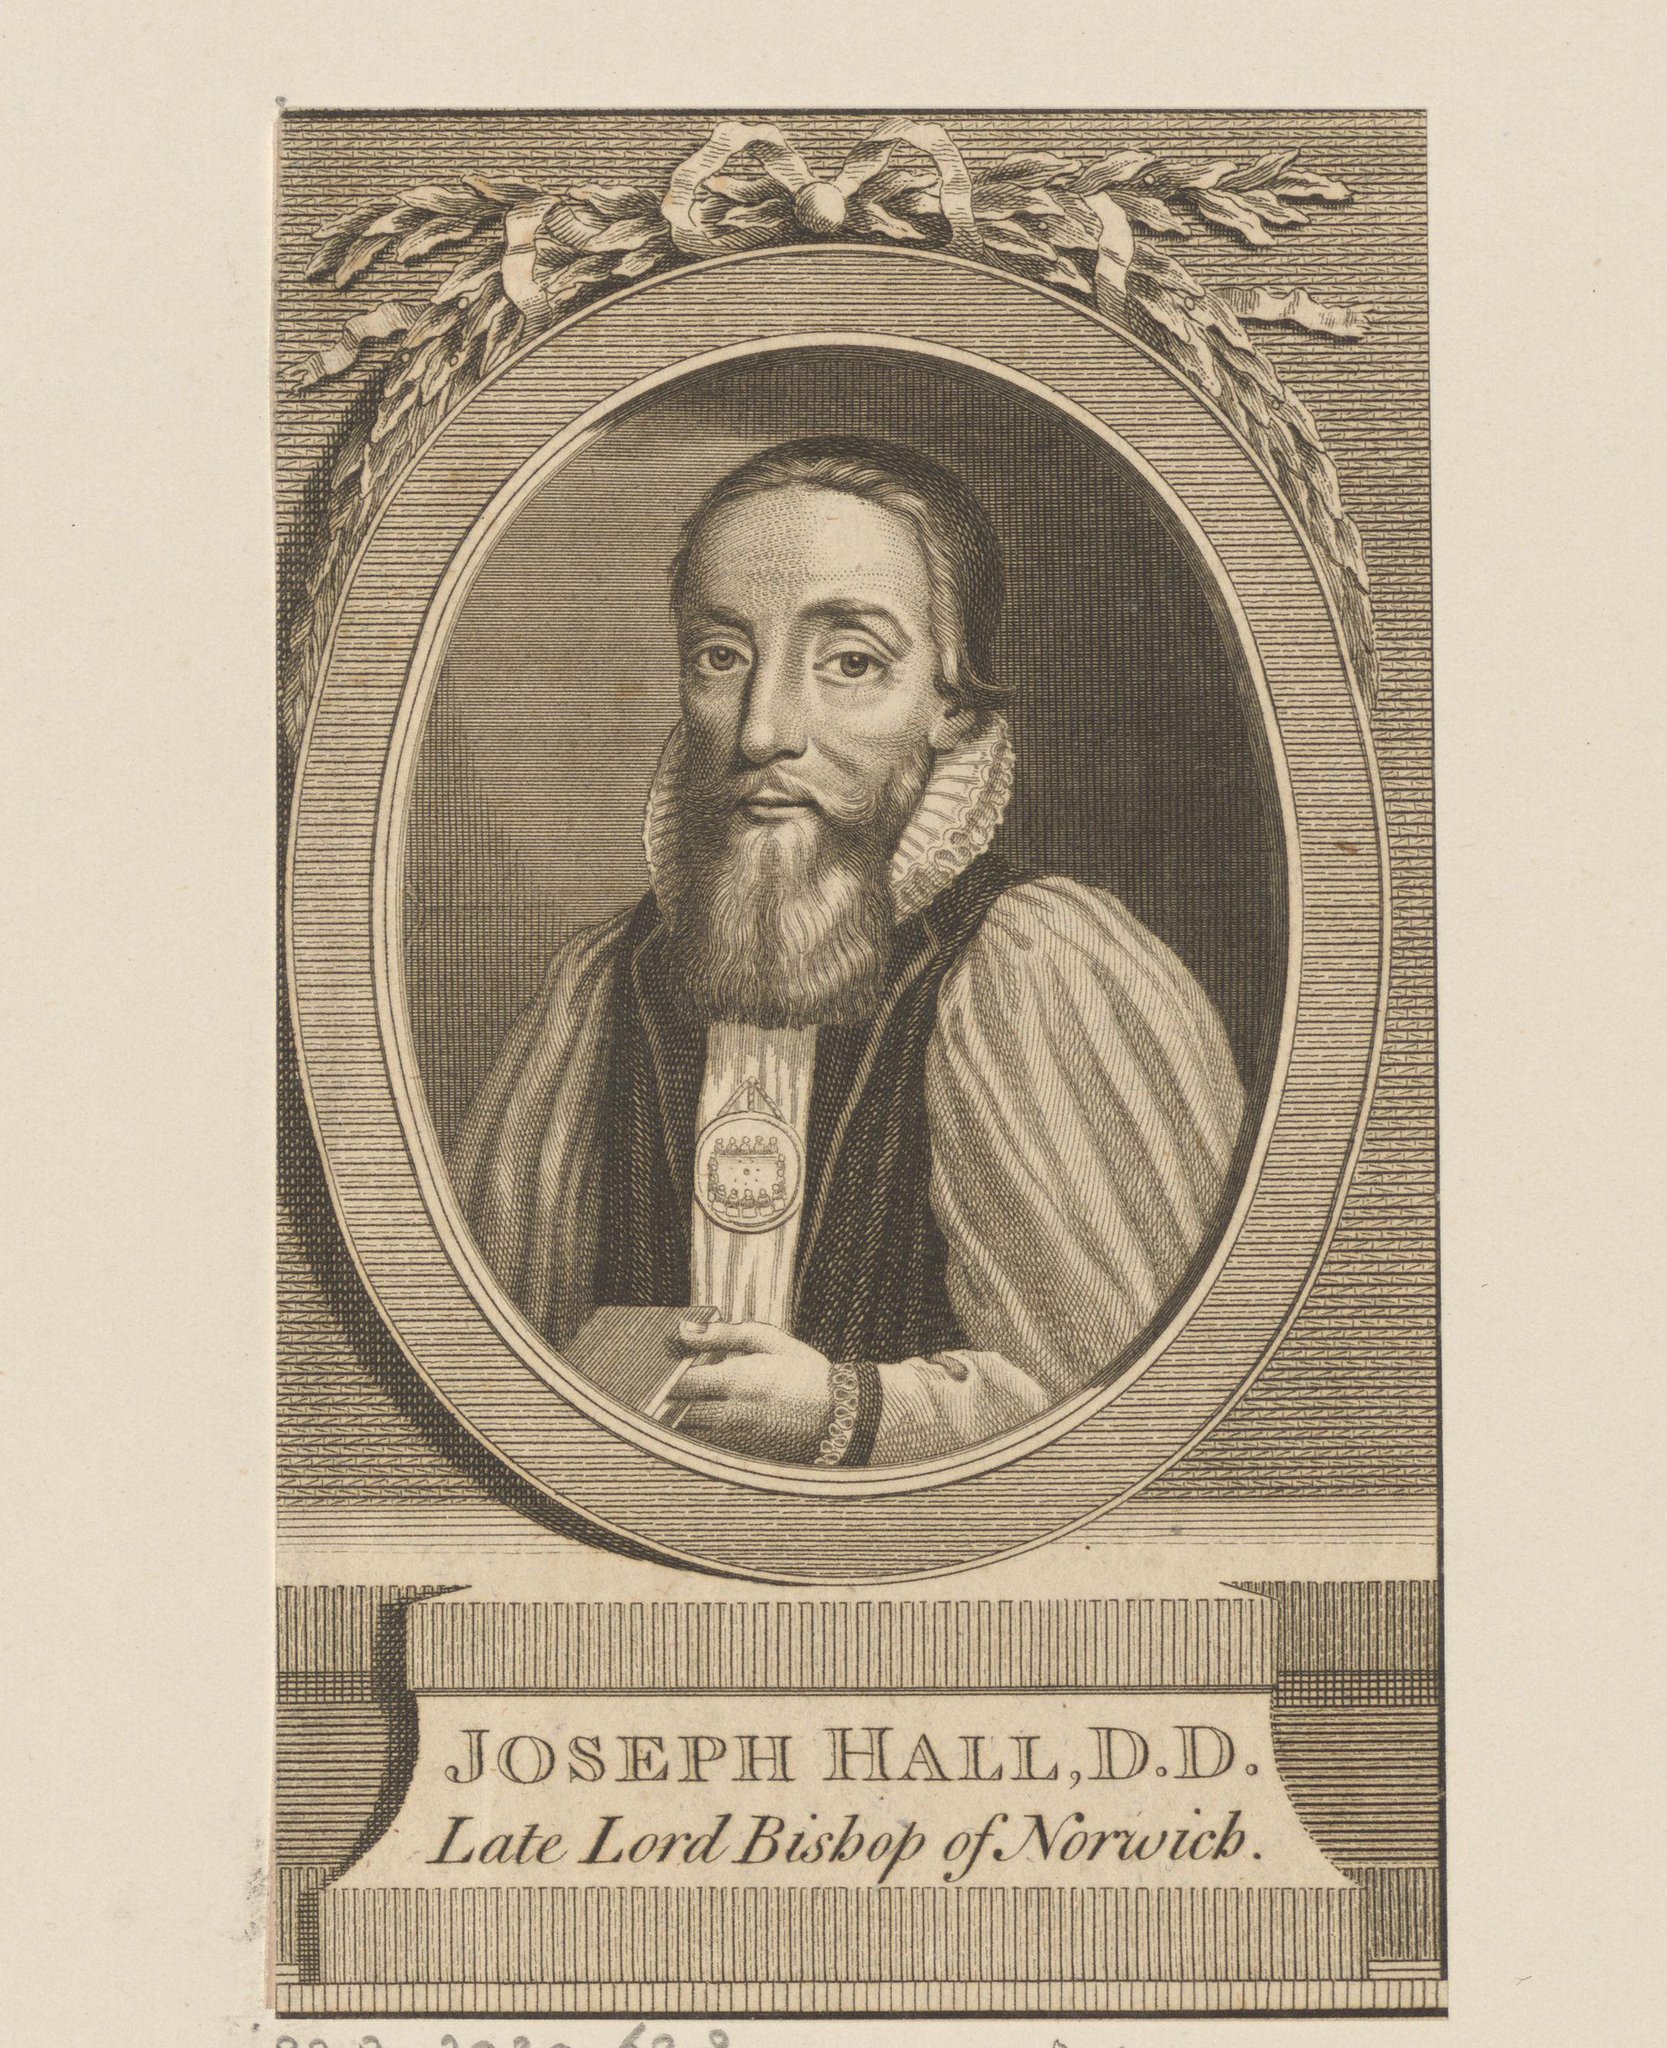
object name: print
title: Portret van Joseph Hall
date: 1784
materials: paper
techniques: engraving, etching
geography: london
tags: theologian, historical persons, book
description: Prent uit: The New Christian's Magazine, januari 1784.